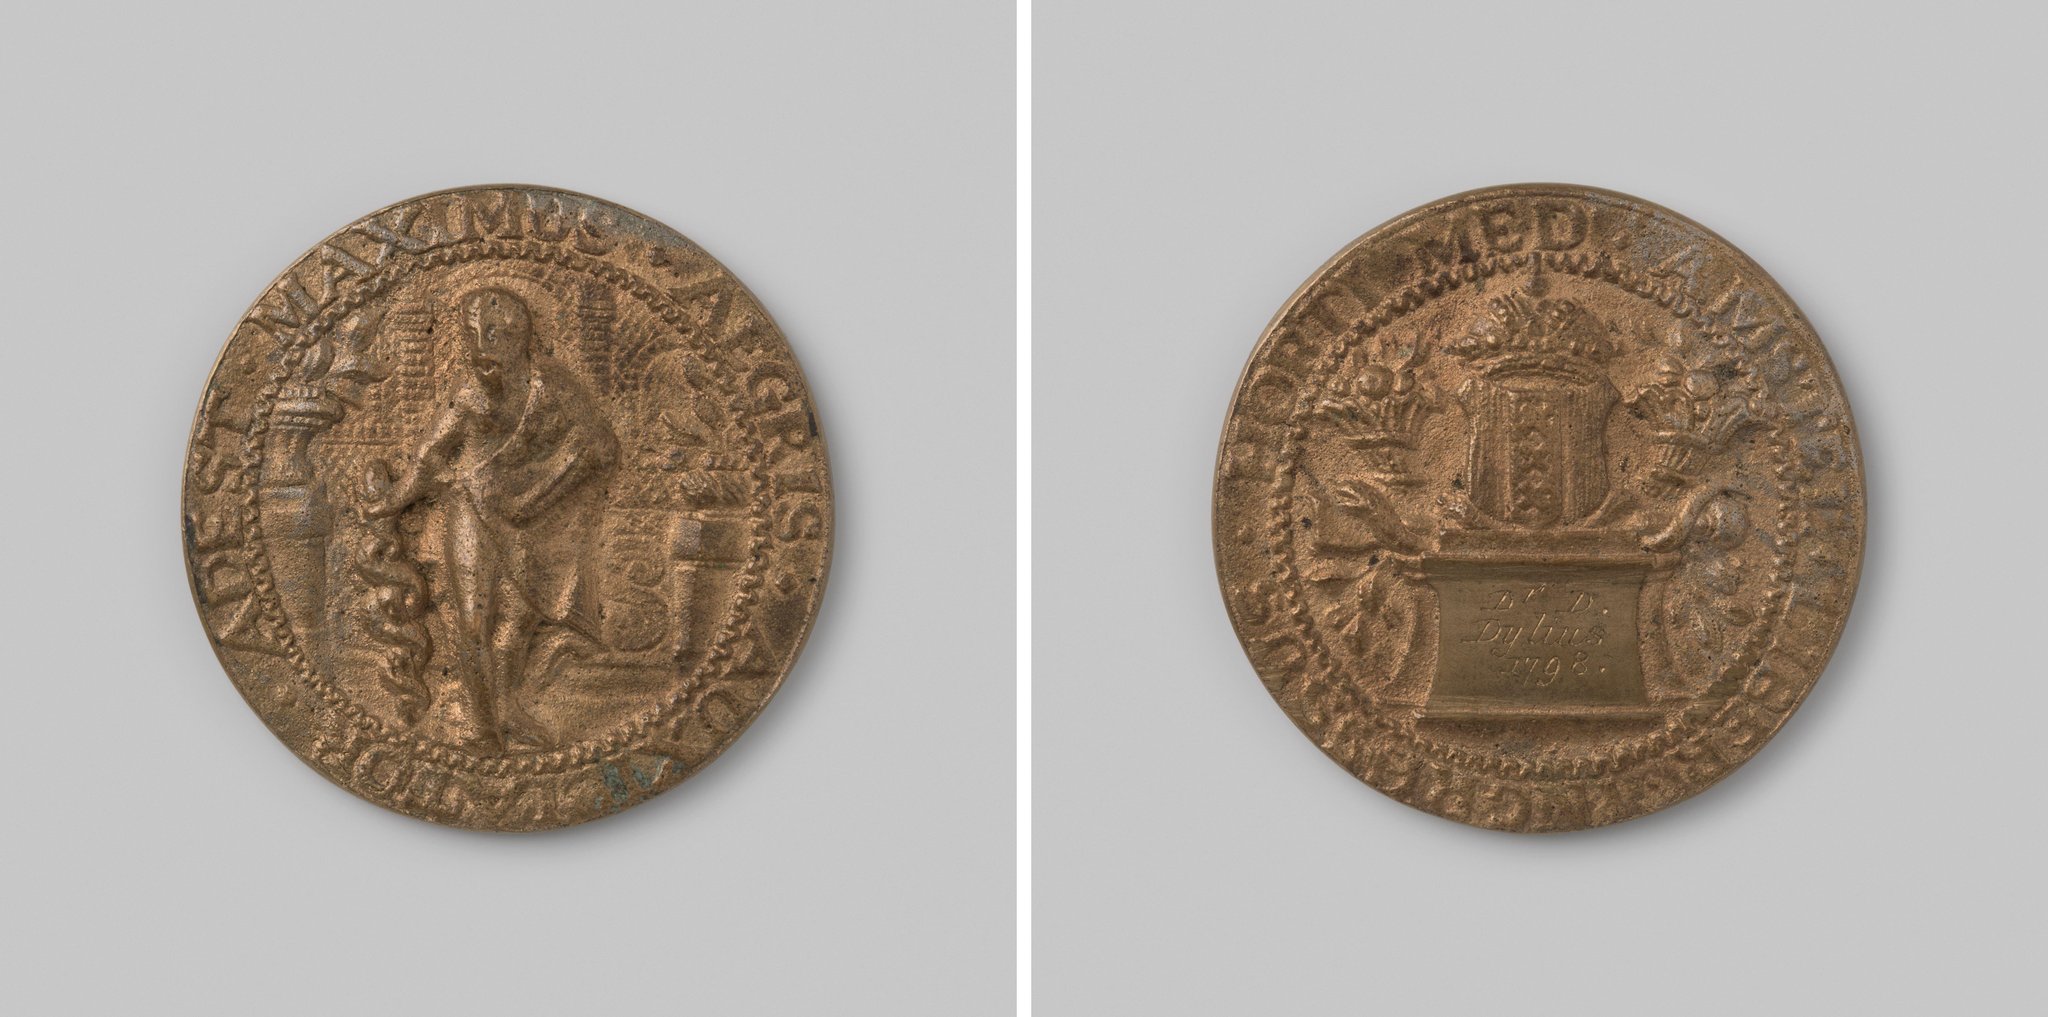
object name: history medal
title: Toegangspenning tot de Hortus Medicus te Amsterdam 1696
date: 1696-1699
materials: brass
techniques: casting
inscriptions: circumscription: ‘HORTI MED AMSTEL LIBER INGRESSUS’, inscription: ‘Dr. D. / Dylius / 1798.’, circumscription: ‘MAXIMUS AEGRIS AUXILIATOR ADEST’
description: Gegoten messing penning met op de voorzijde Aesculapius en op de keerzijde een altaar waarop het gekroonde stadswapen, een caduceus en cornucopiae waaruit kruidentakken, op naam van Dr.D. Dylius 1798.